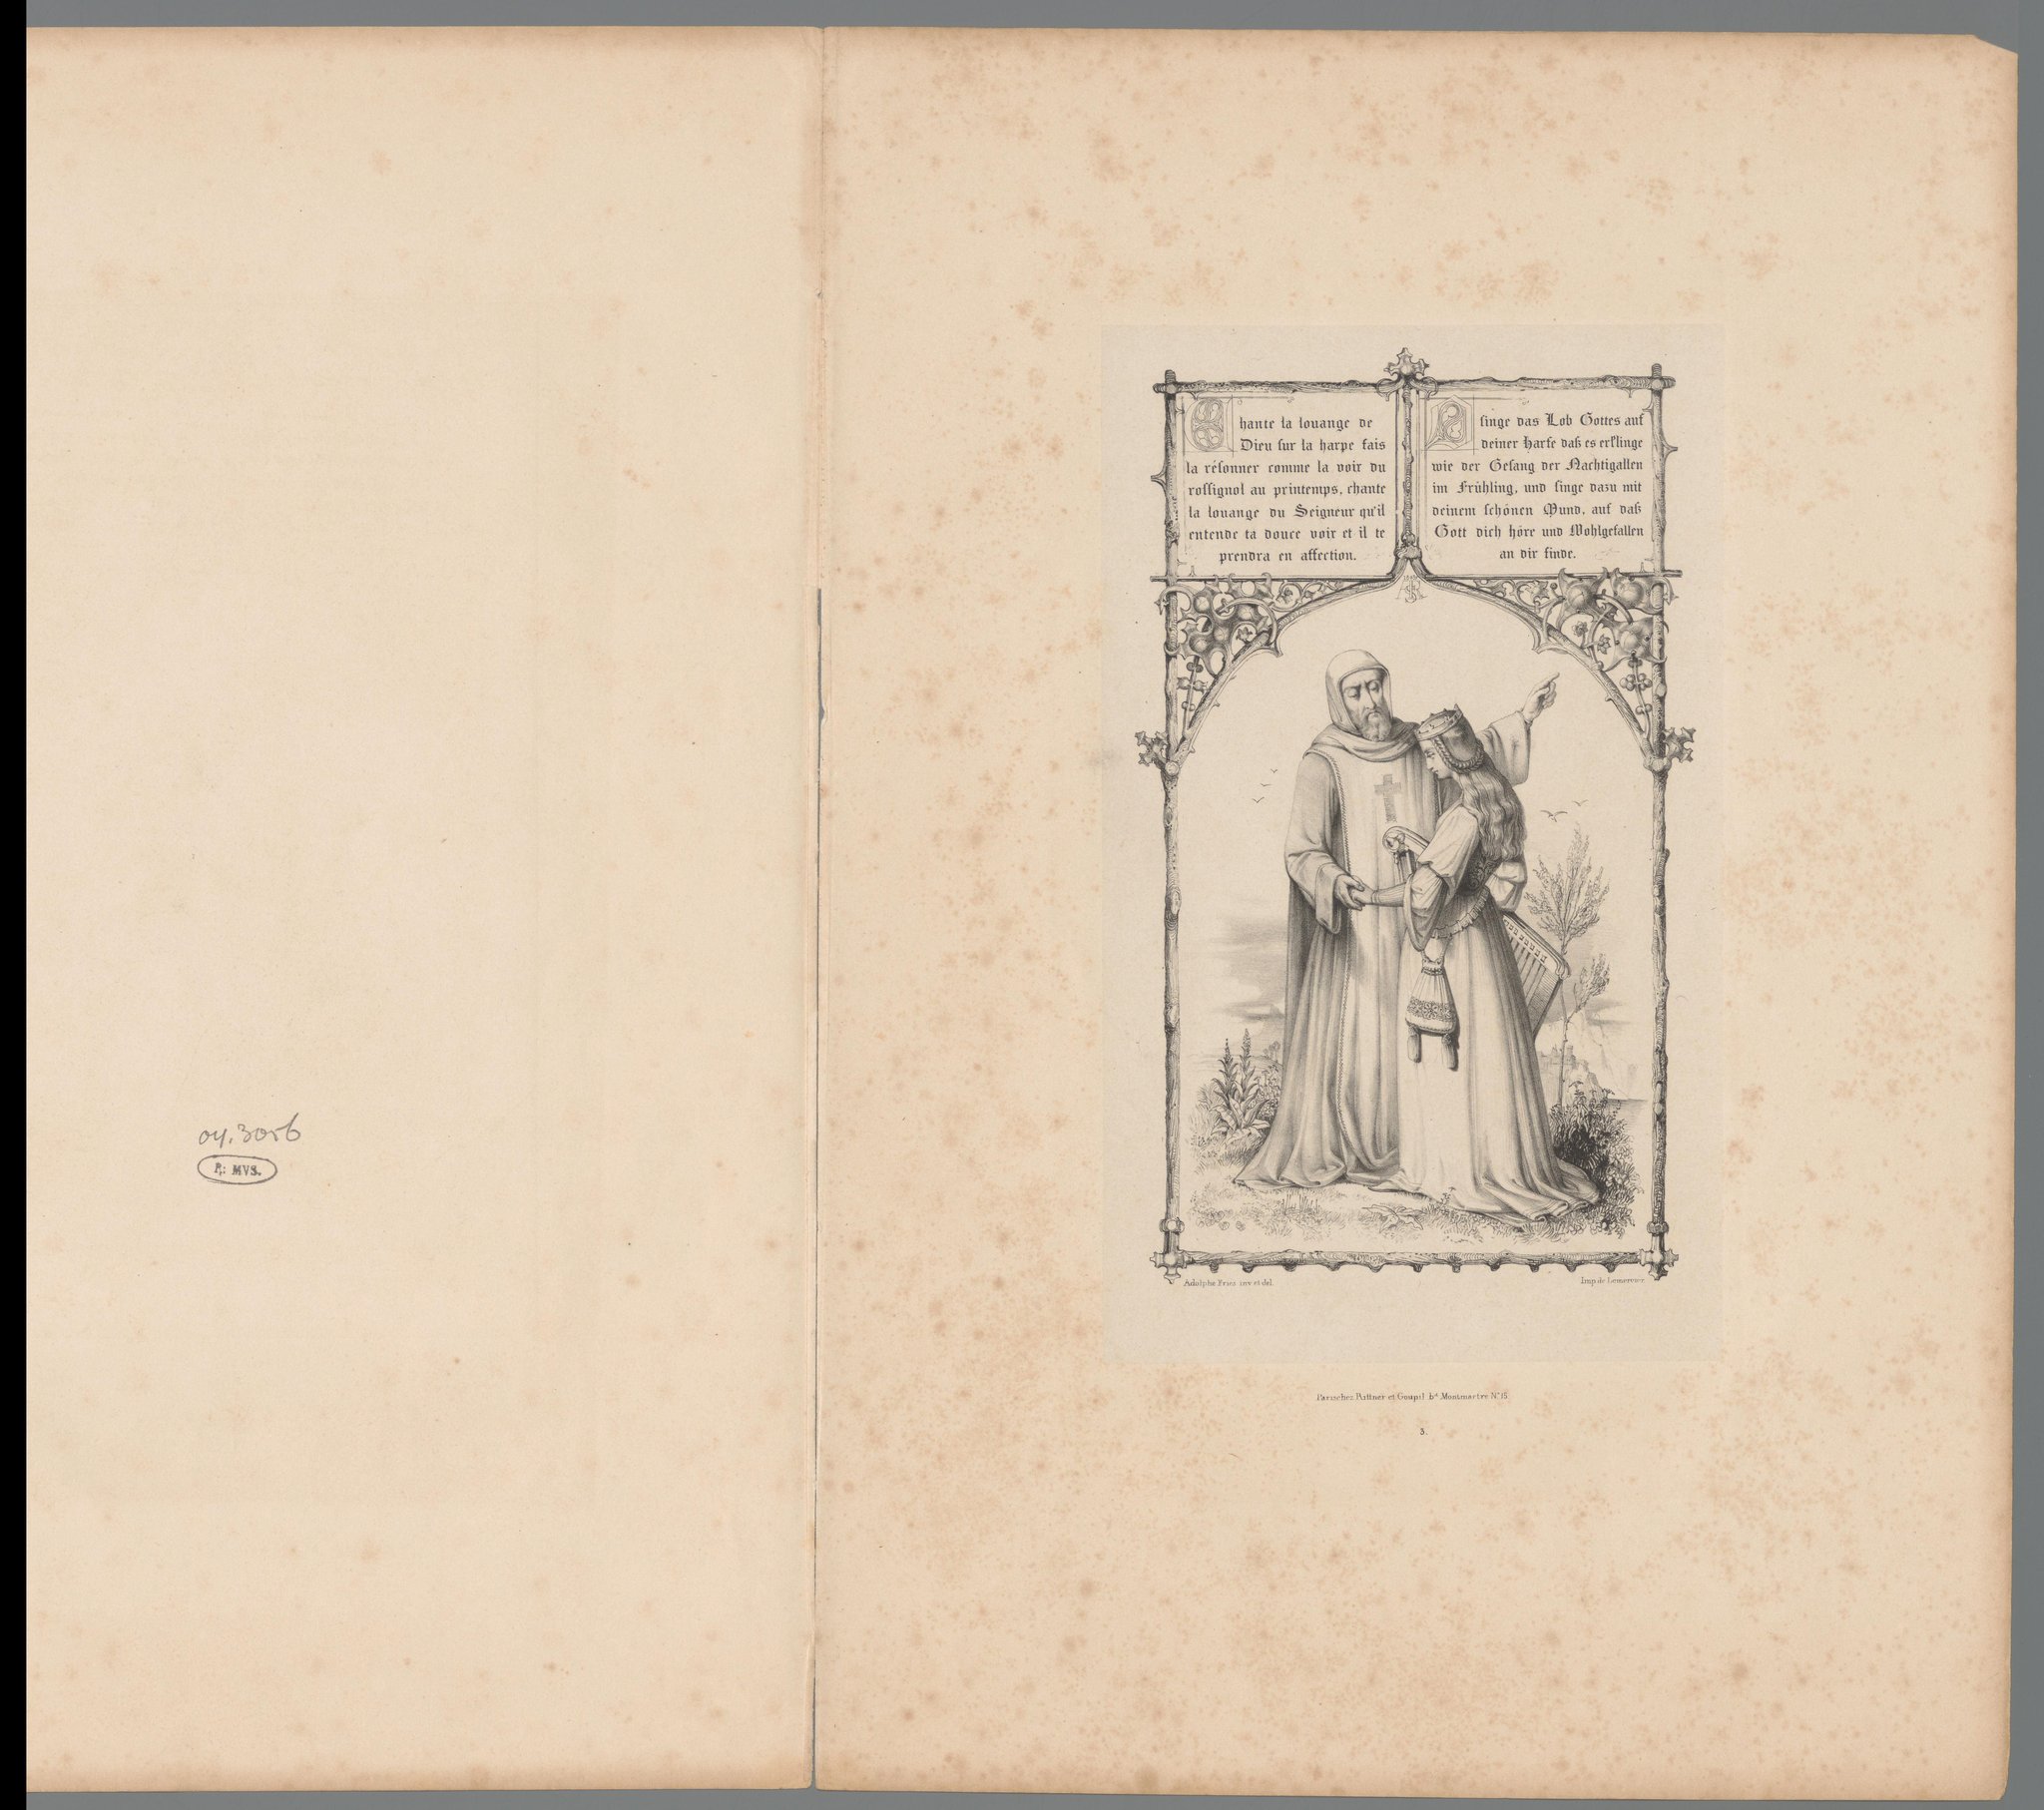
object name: print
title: Woorden van de ziel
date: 1837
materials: paper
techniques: lithograph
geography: paris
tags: adult woman, adult man, harp, index finger forwards, pointing, indicating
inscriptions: collector's mark: Lugt 2228